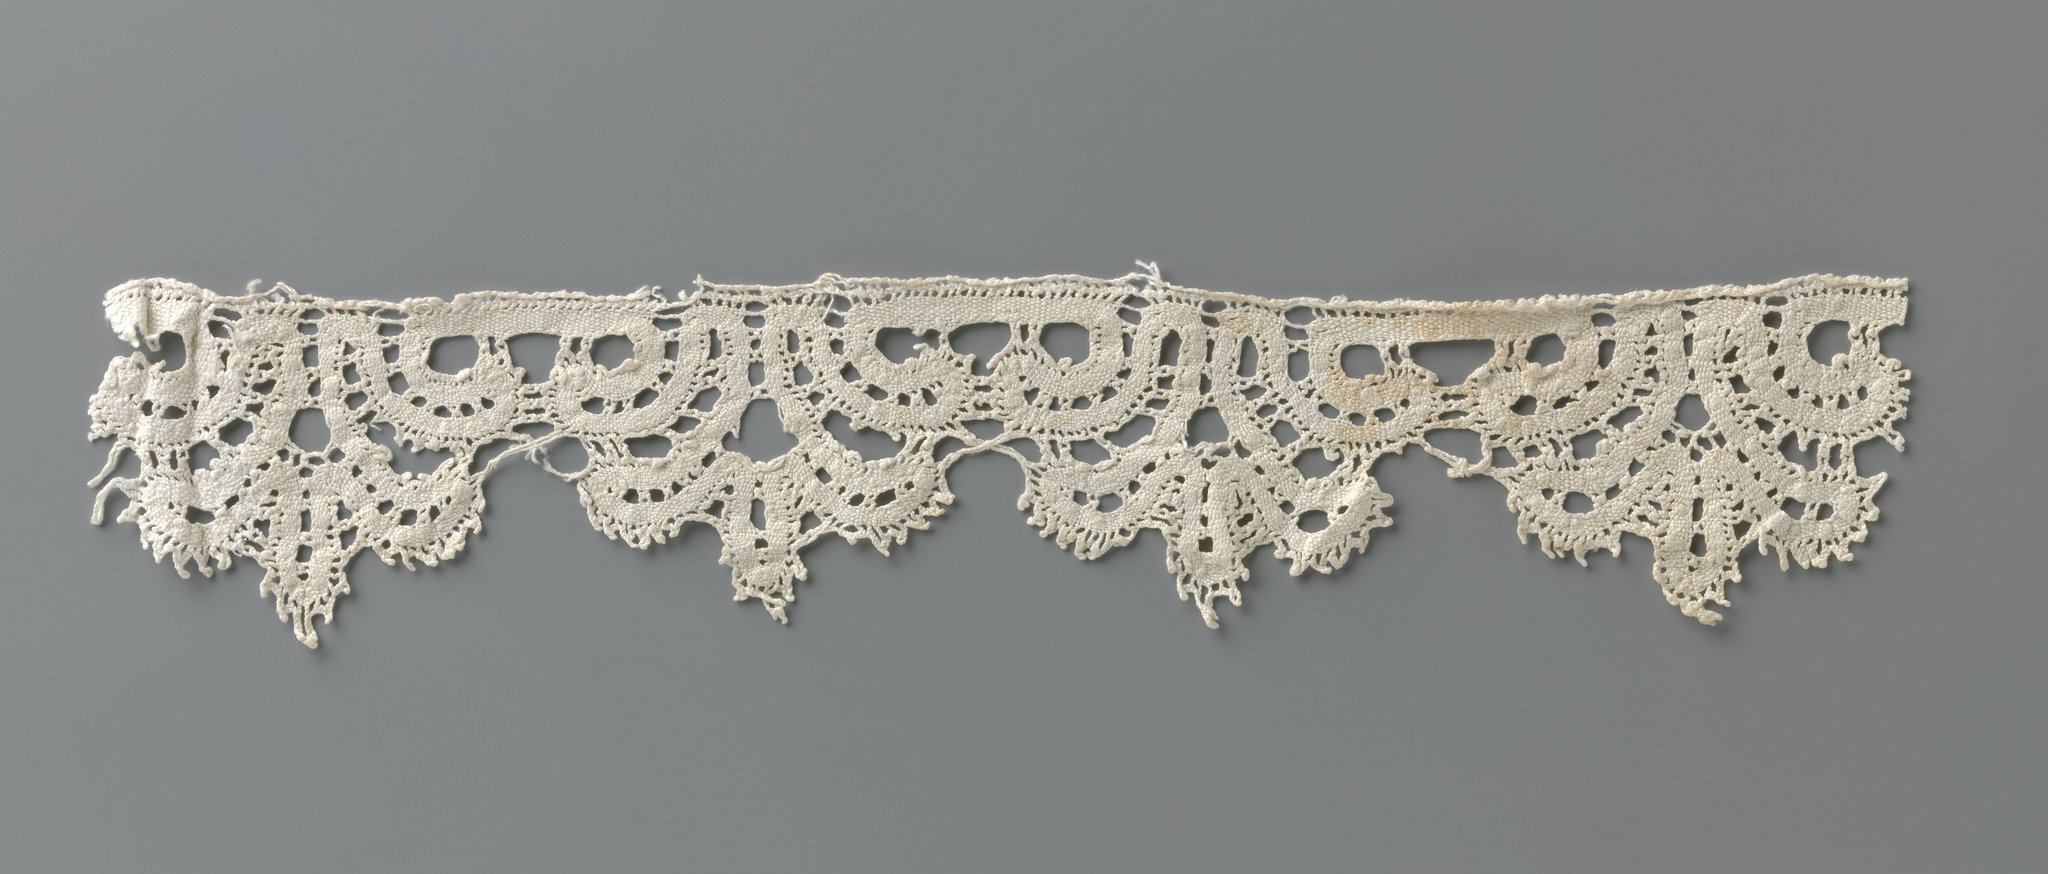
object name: strip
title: Strook kloskant gemaakt naar Italiaanse voorbeeld uit de 17e eeuw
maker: Anonymous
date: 1900-1920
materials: linen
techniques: lace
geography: italy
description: Strook naturelkleurige kloskant: lintkant. Gemaakt naar Italiaans voorbeeld uit de 17e eeuw. Het zich herhalende en symmetrische patroon bestaat uit schulpen van vijflobbige waaiervormige bladeren die zijn gevormd door een doorgaand slingerend lint. Het lint is geklost in linnenslag met opengewerkte randjes aan één zijde, die bovendien is voorzien van picots. De bovenzijde van de strook is recht afgewerkt.